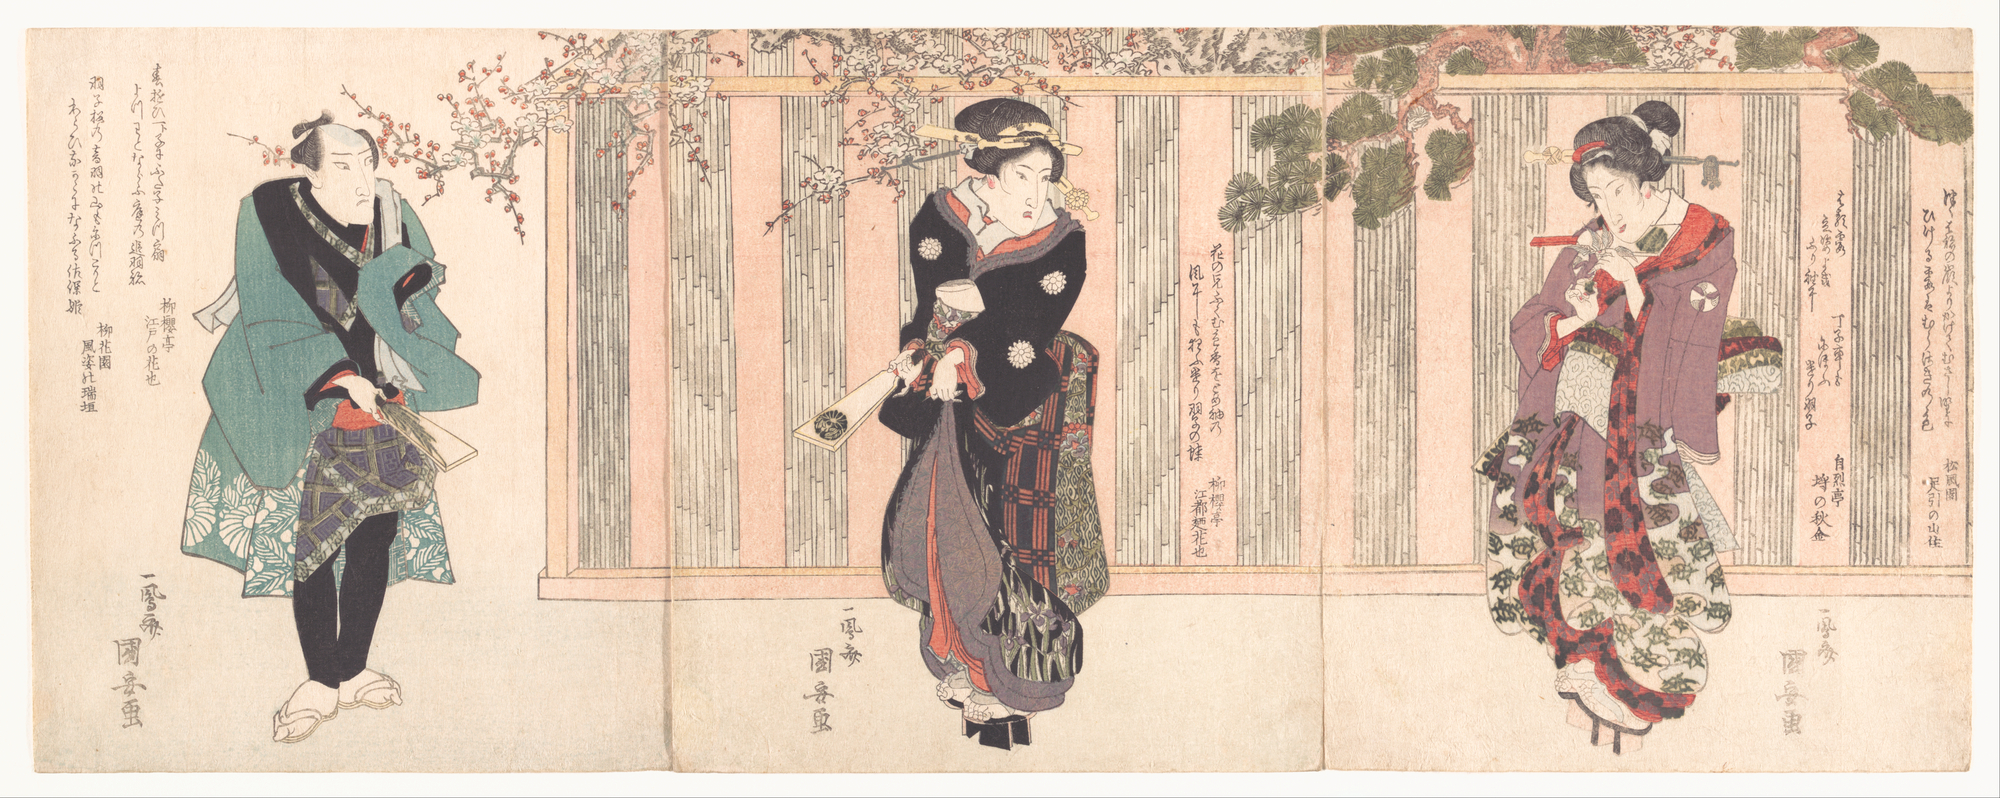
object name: print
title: Three Kabuki Actors Playing Hanetsuki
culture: japanese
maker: utagawa kuniyasu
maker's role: artist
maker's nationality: japanese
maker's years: 1794-1834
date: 1823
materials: ink, paper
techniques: surimono, woodblock print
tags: men,women,actors